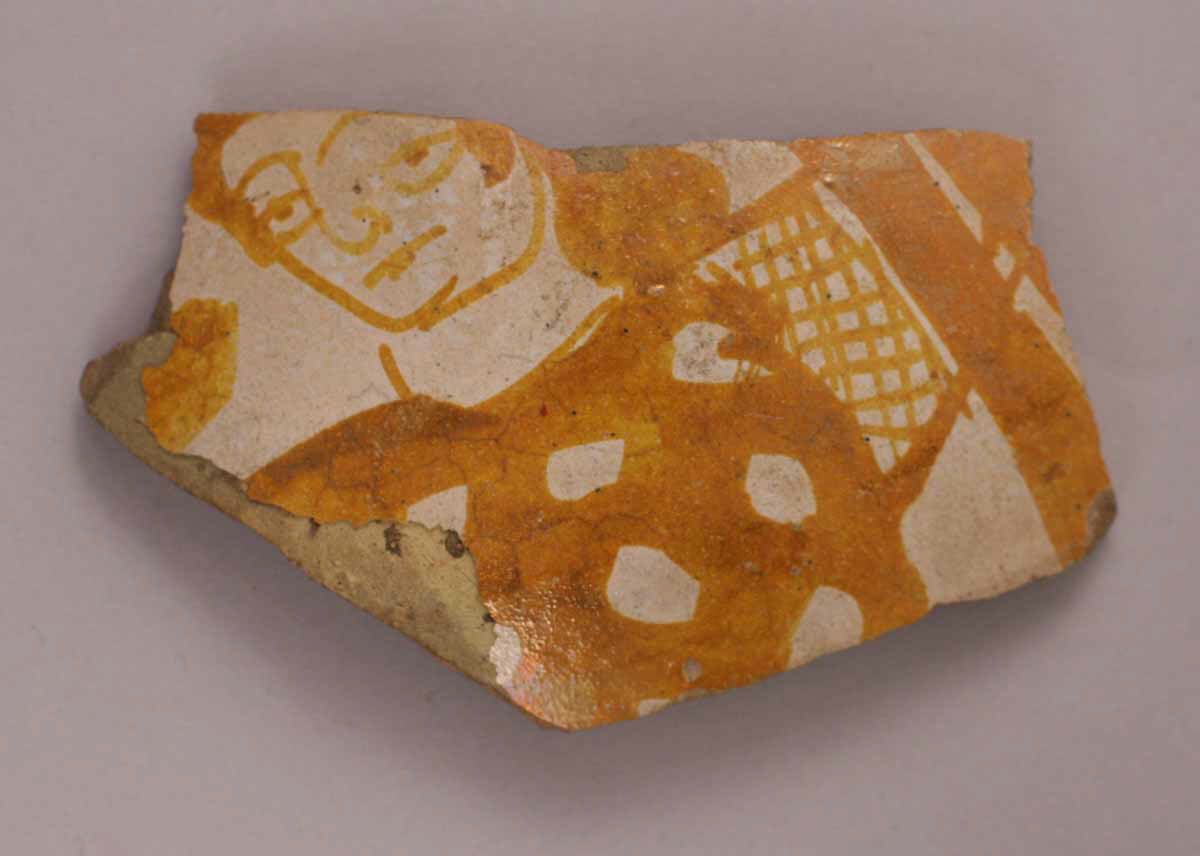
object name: fragment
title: Ceramic Fragment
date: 1101-1200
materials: glaze, stonepaste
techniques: painting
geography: syria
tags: faces